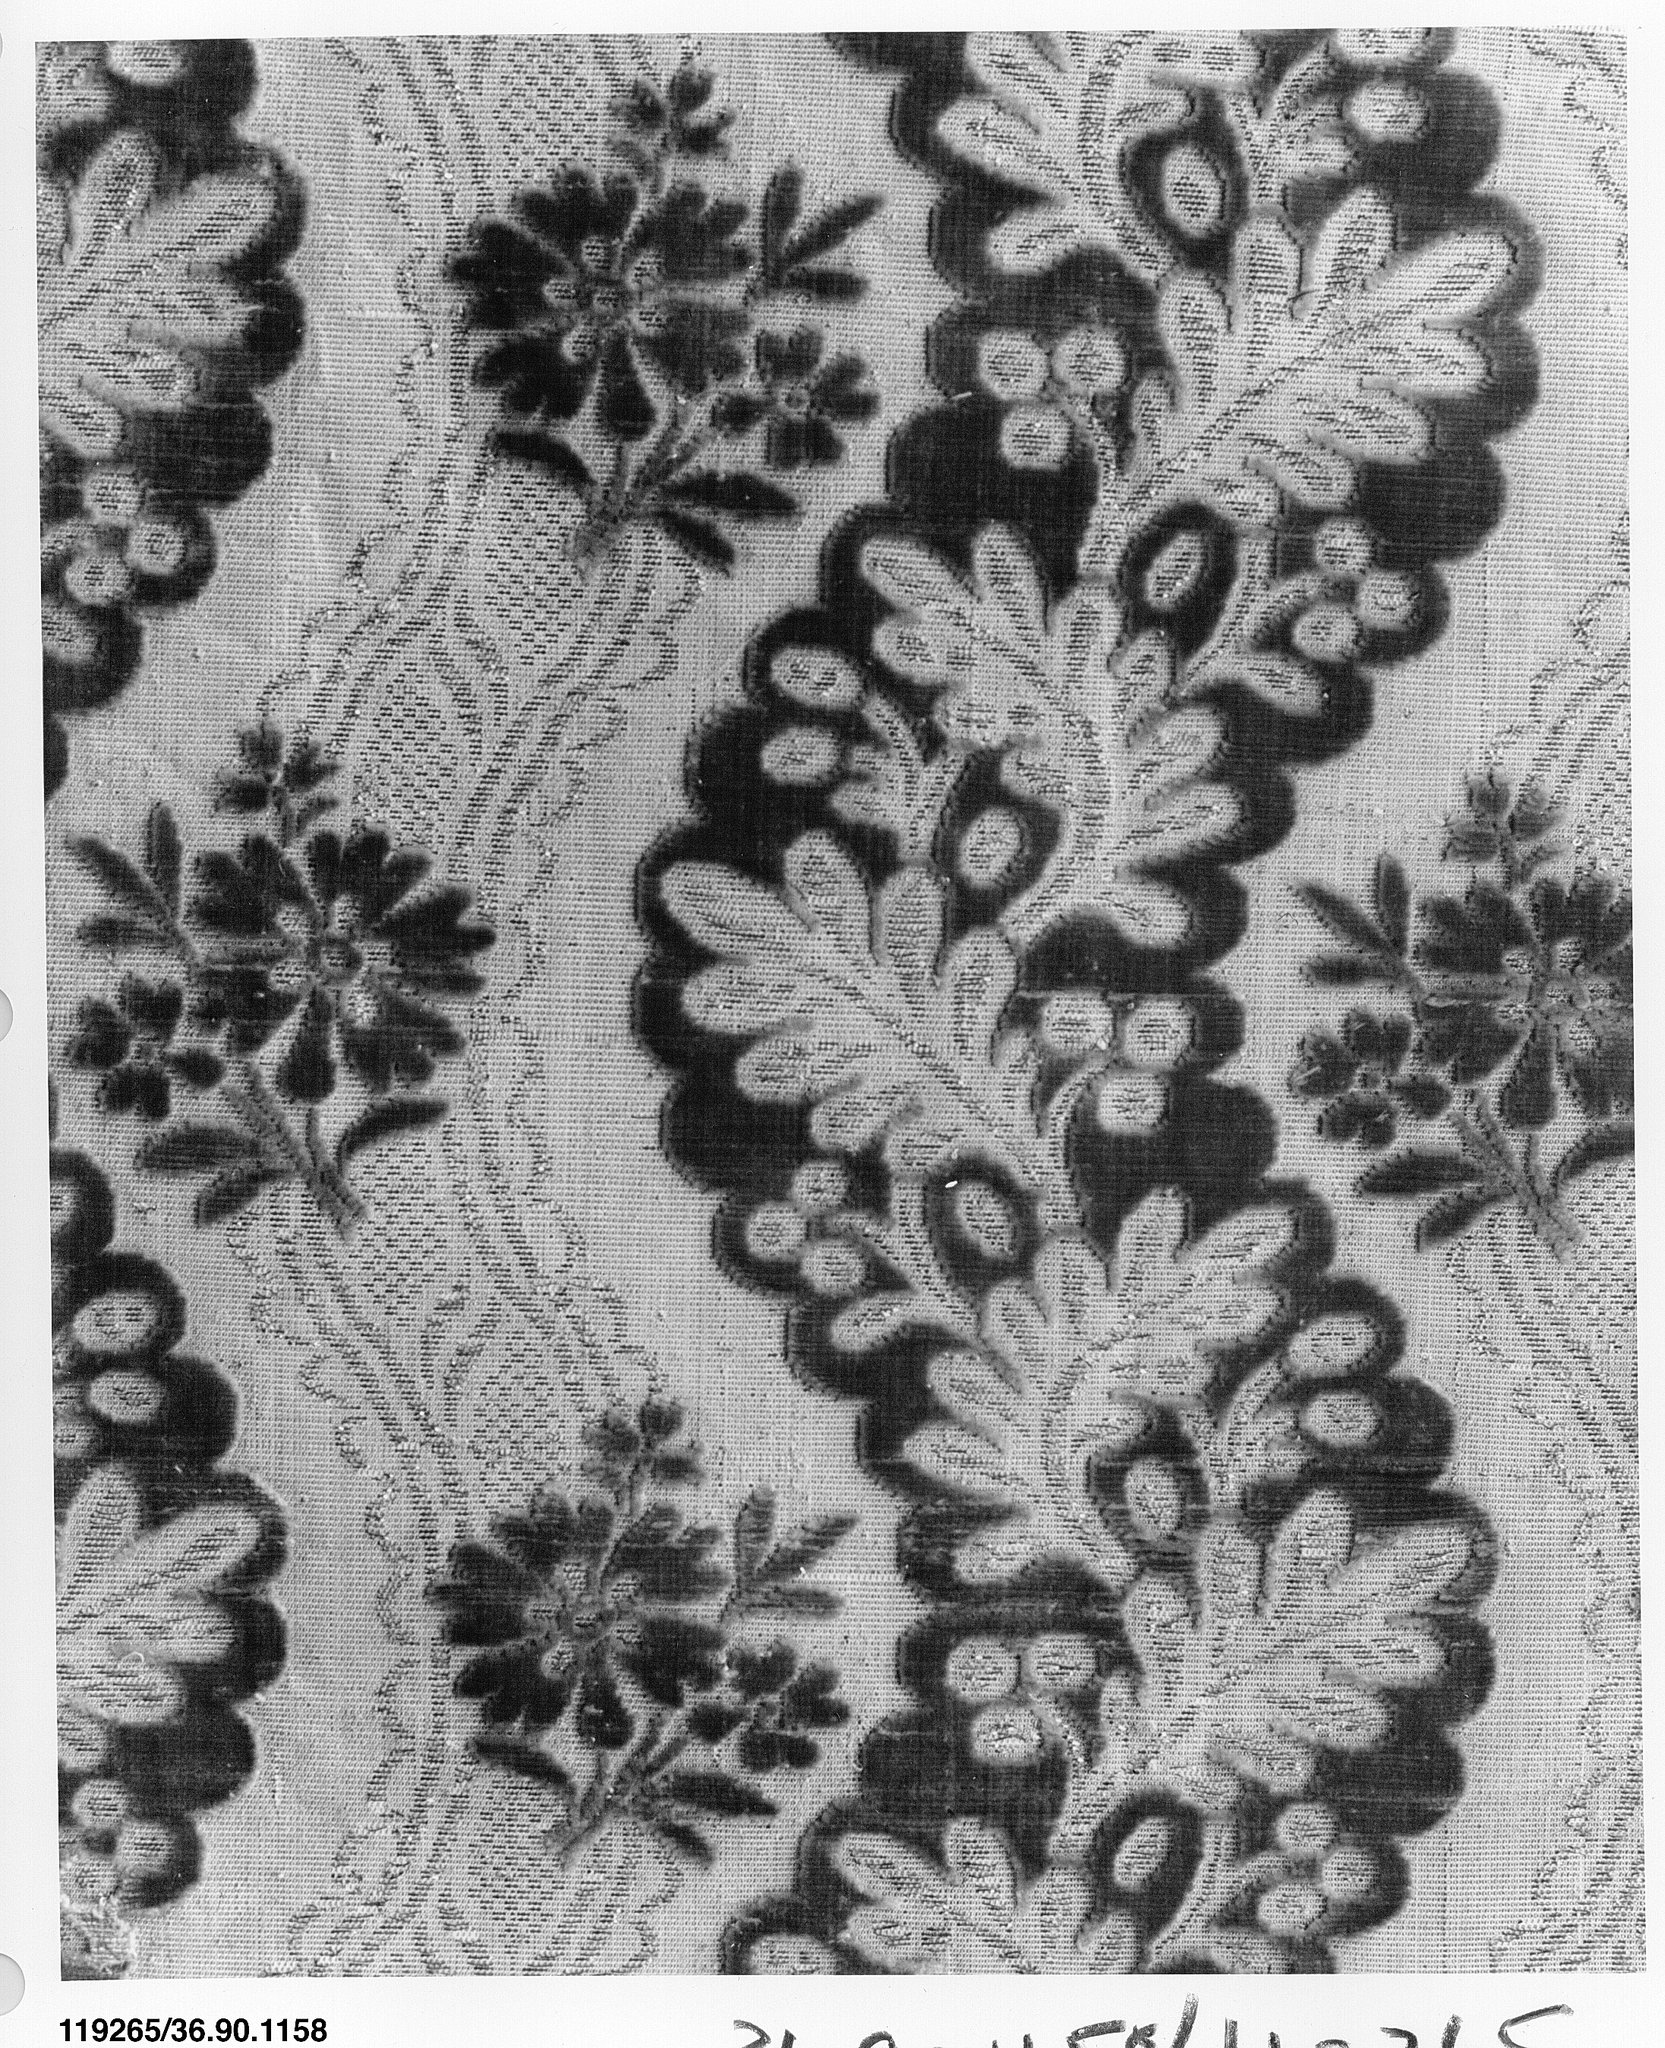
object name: piece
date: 1701-1800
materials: metal thread, silk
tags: flowers,leaves